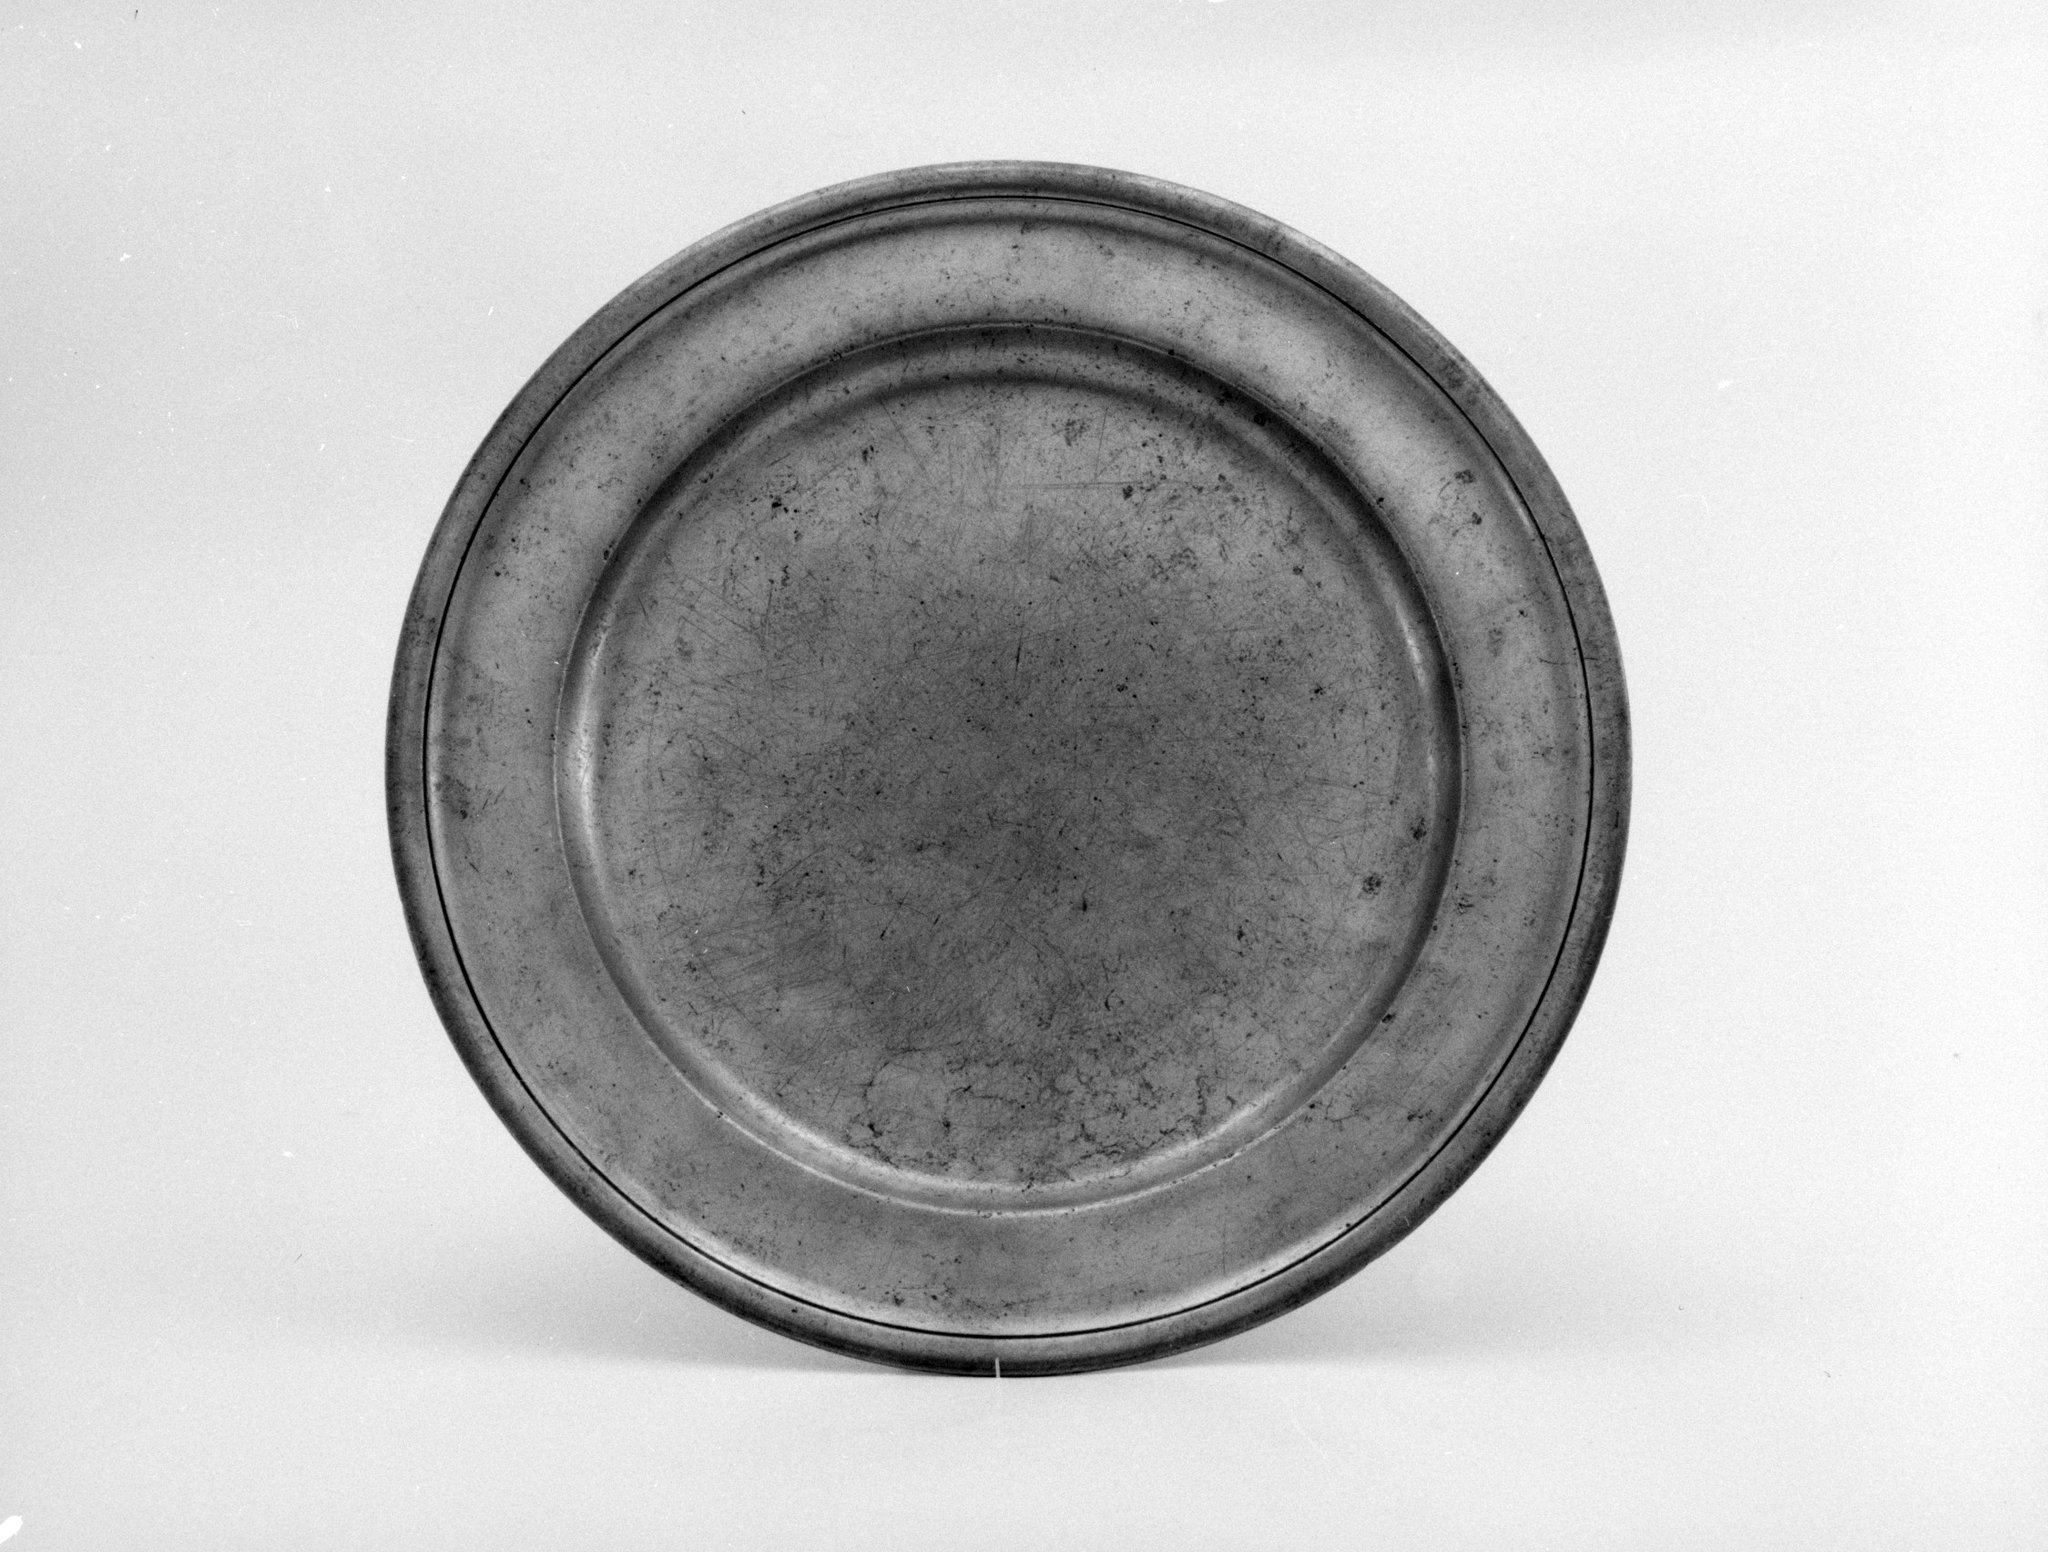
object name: plate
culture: american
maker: thomas byles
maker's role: maker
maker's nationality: american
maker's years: 1682-1771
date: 1711-1771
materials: pewter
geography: united states